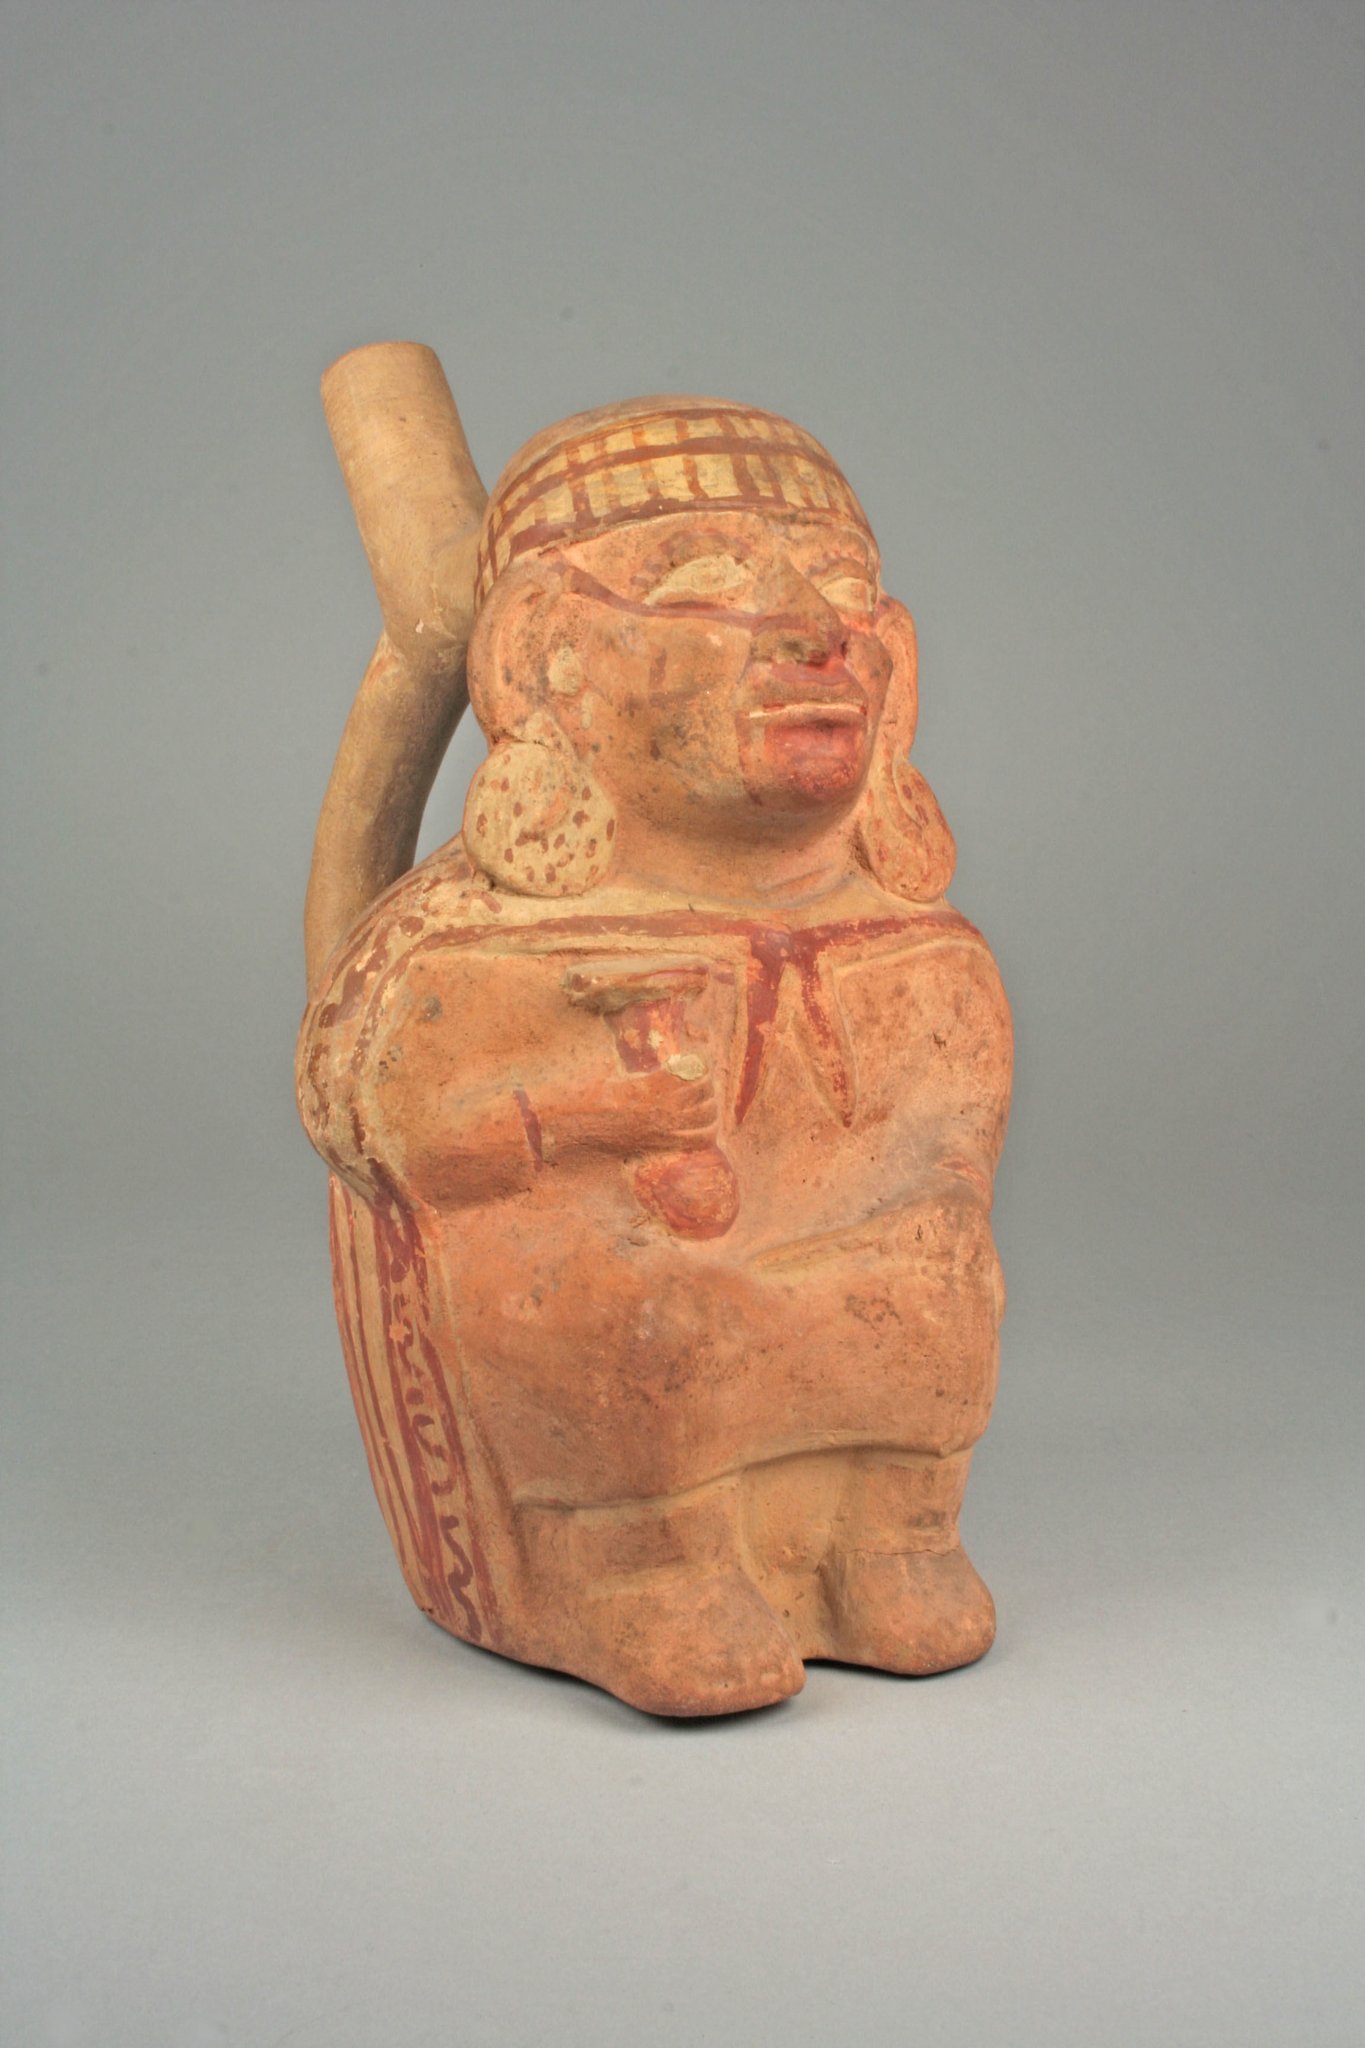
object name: bottle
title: Stirrup Spout Bottle with Figure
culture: moche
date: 301-700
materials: ceramic, pigment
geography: peru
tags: human figures